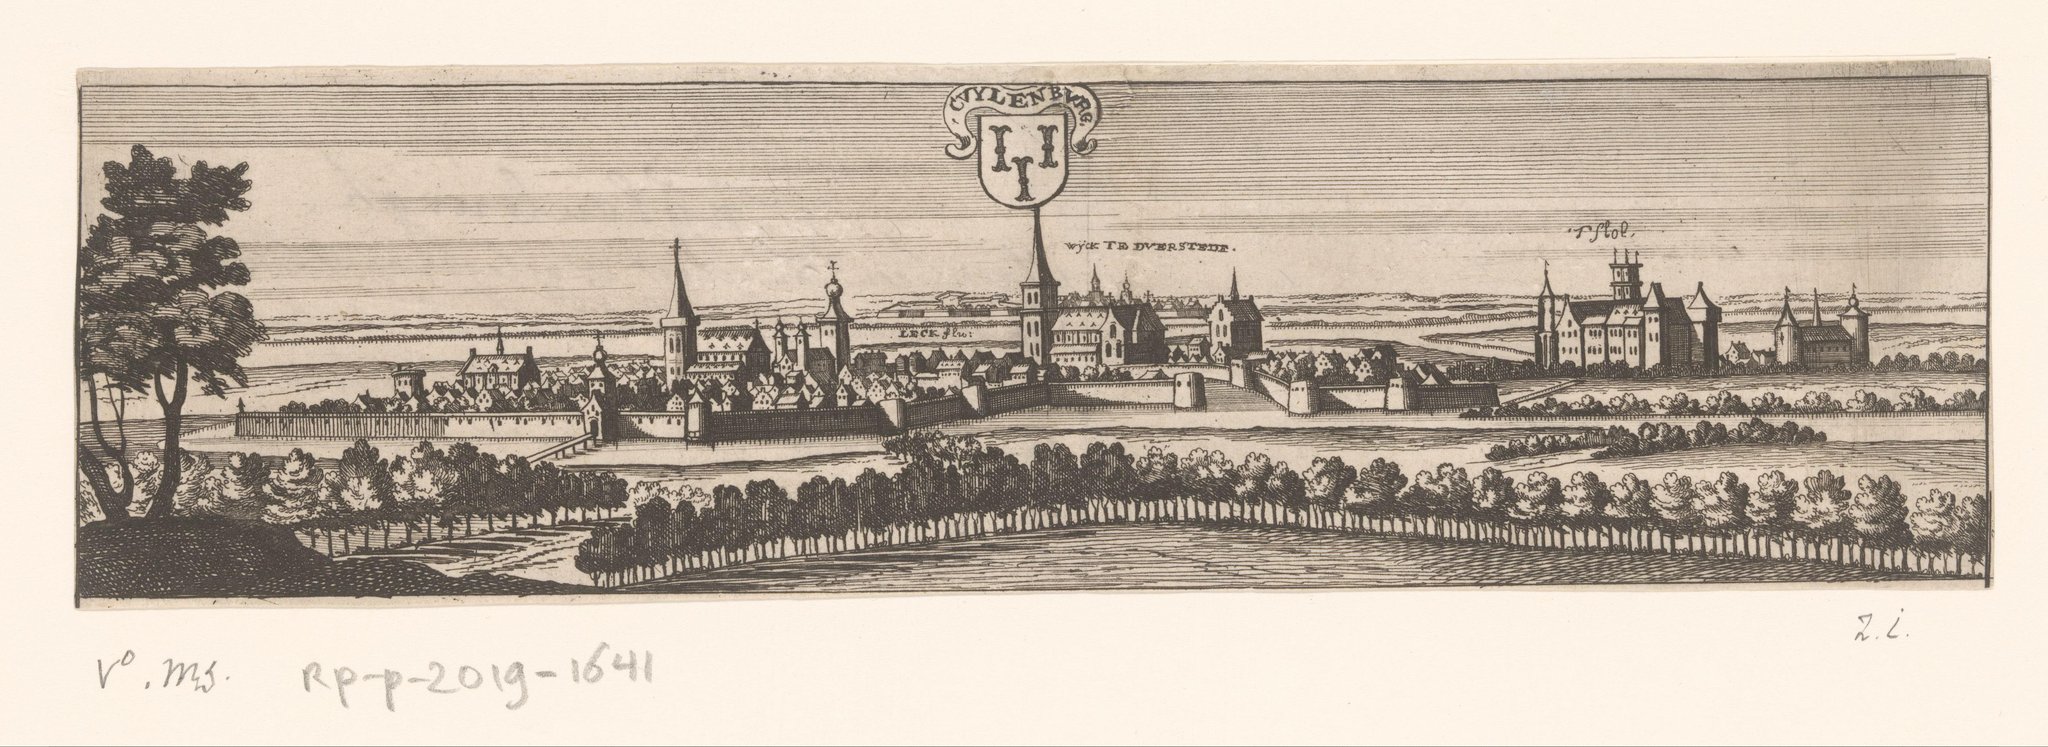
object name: print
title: Thooneel der Steden ende Sterckten van 't Vereenight Nederlandt met d'aengrensende Plaetsen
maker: gaspar bouttats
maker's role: print maker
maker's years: 1640-1695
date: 1674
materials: paper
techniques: etching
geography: antwerp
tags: city-view, and landscape with man-made constructions, river, landscape with tower or castle, wijk bij duurstede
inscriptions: inscription: ‘Cuijlenburgh is een leen van Gelder is gelegen op de slincke zij van den watervloet Lecke, een mijle van bueren het een goede stadt wijt ende breet streckende met [...] heerlijckhijdt, is van den coninck Philippus ver[...]ven tot een graefschap, heeft groote privilegien en vrijheden etc.’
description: Prent uit: Peeters, Jan. Thooneel der steden ende sterckten van t'Vereenight Nederlandt (...) / Theatre des villes et fortresses des Provinces Unies (...). Antwerpen: Gaspar Bouttats, 1674.